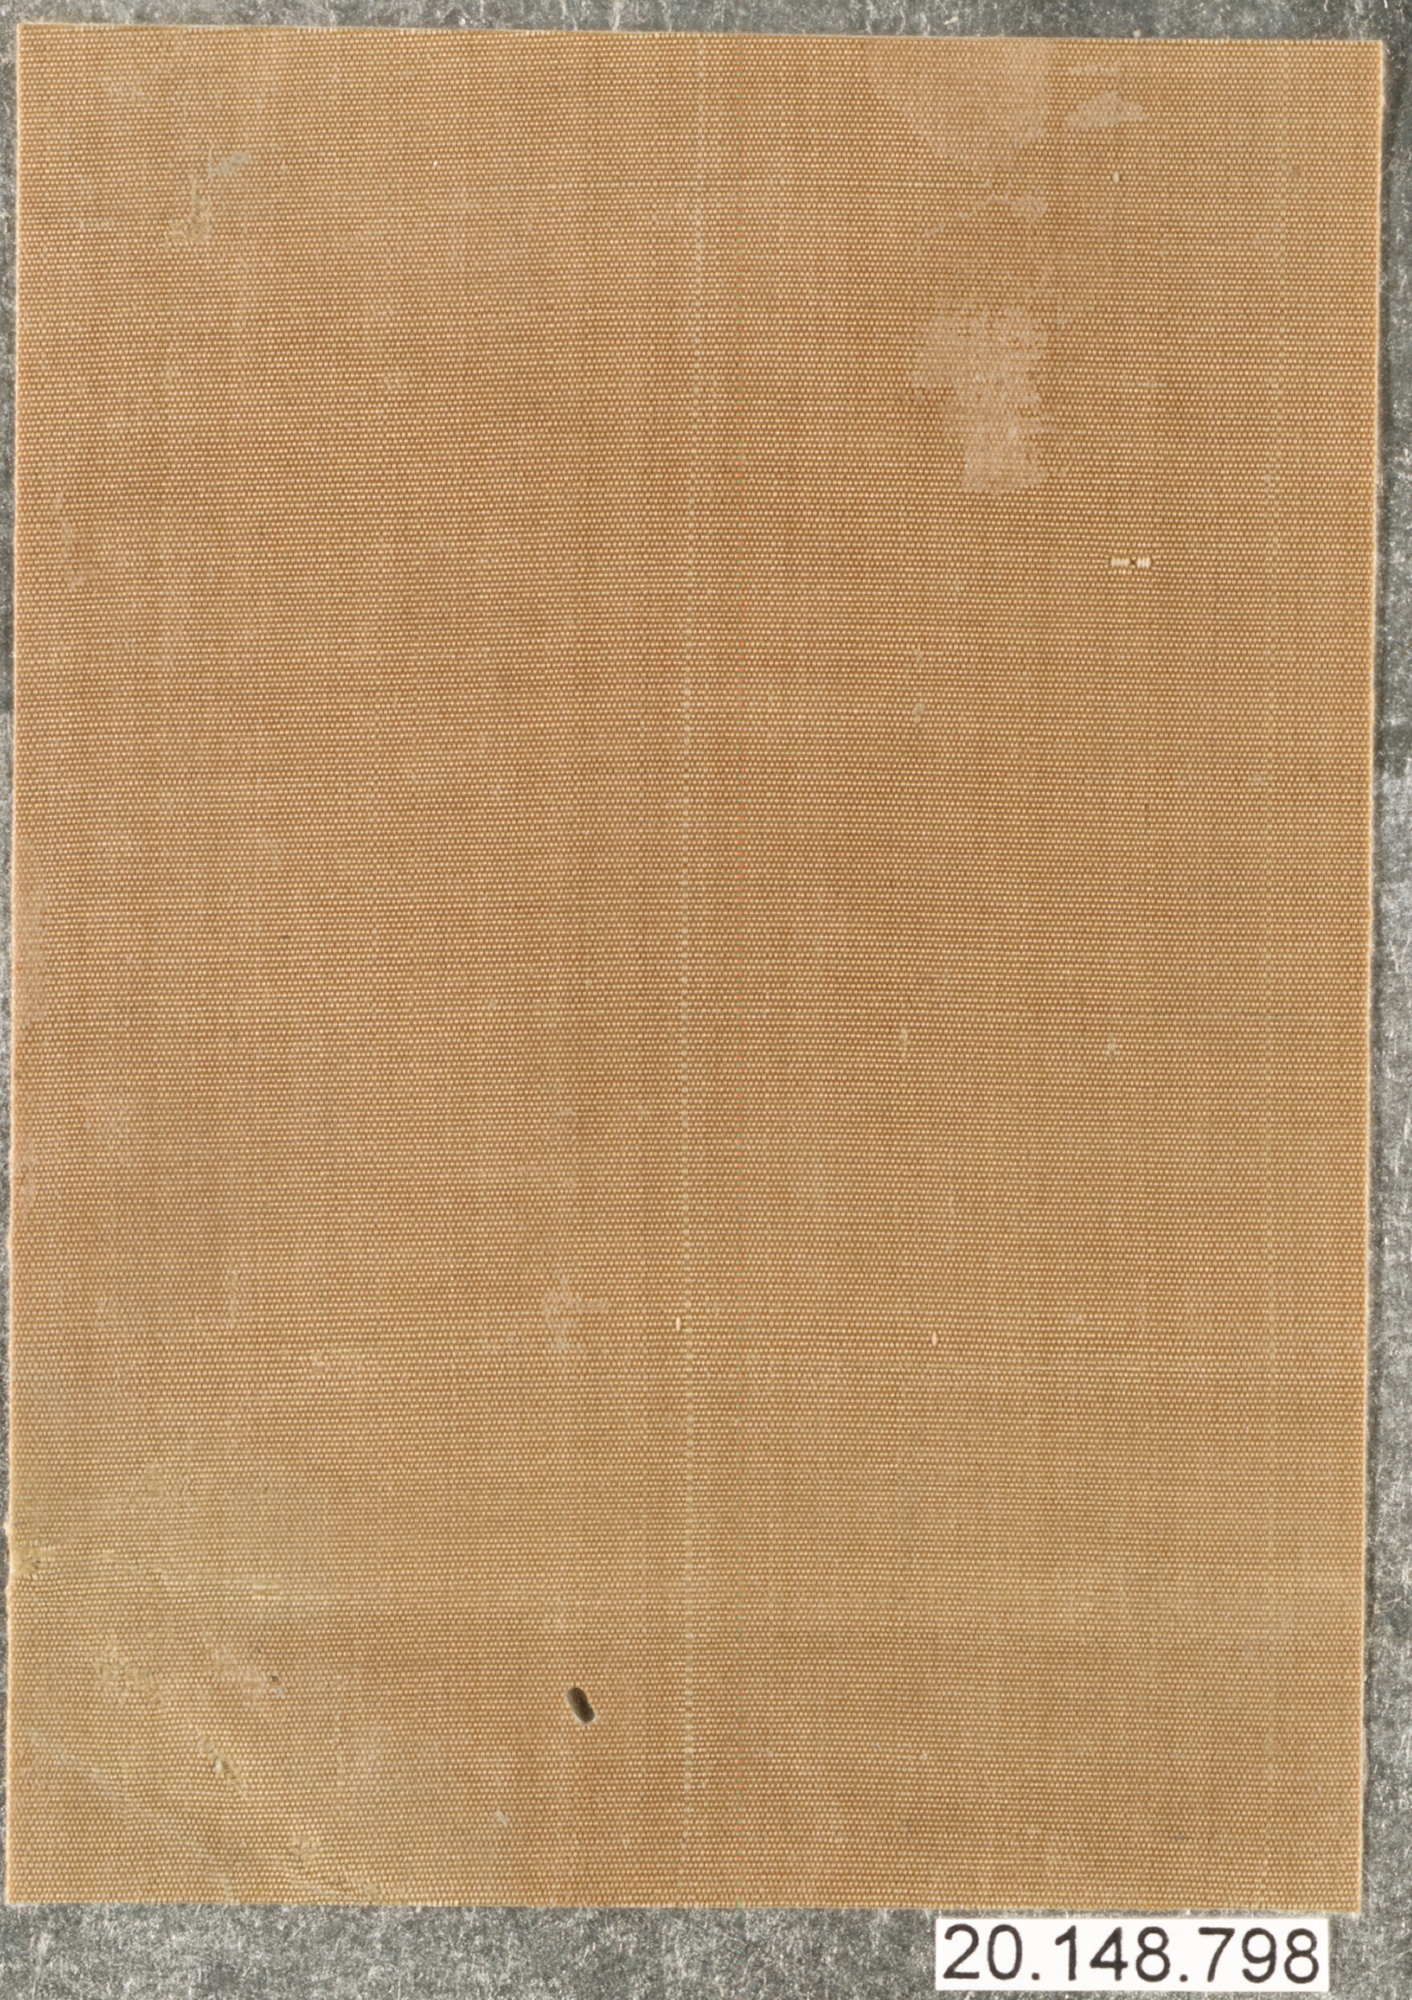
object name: piece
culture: japanese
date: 1701-1800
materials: silk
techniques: compound weave